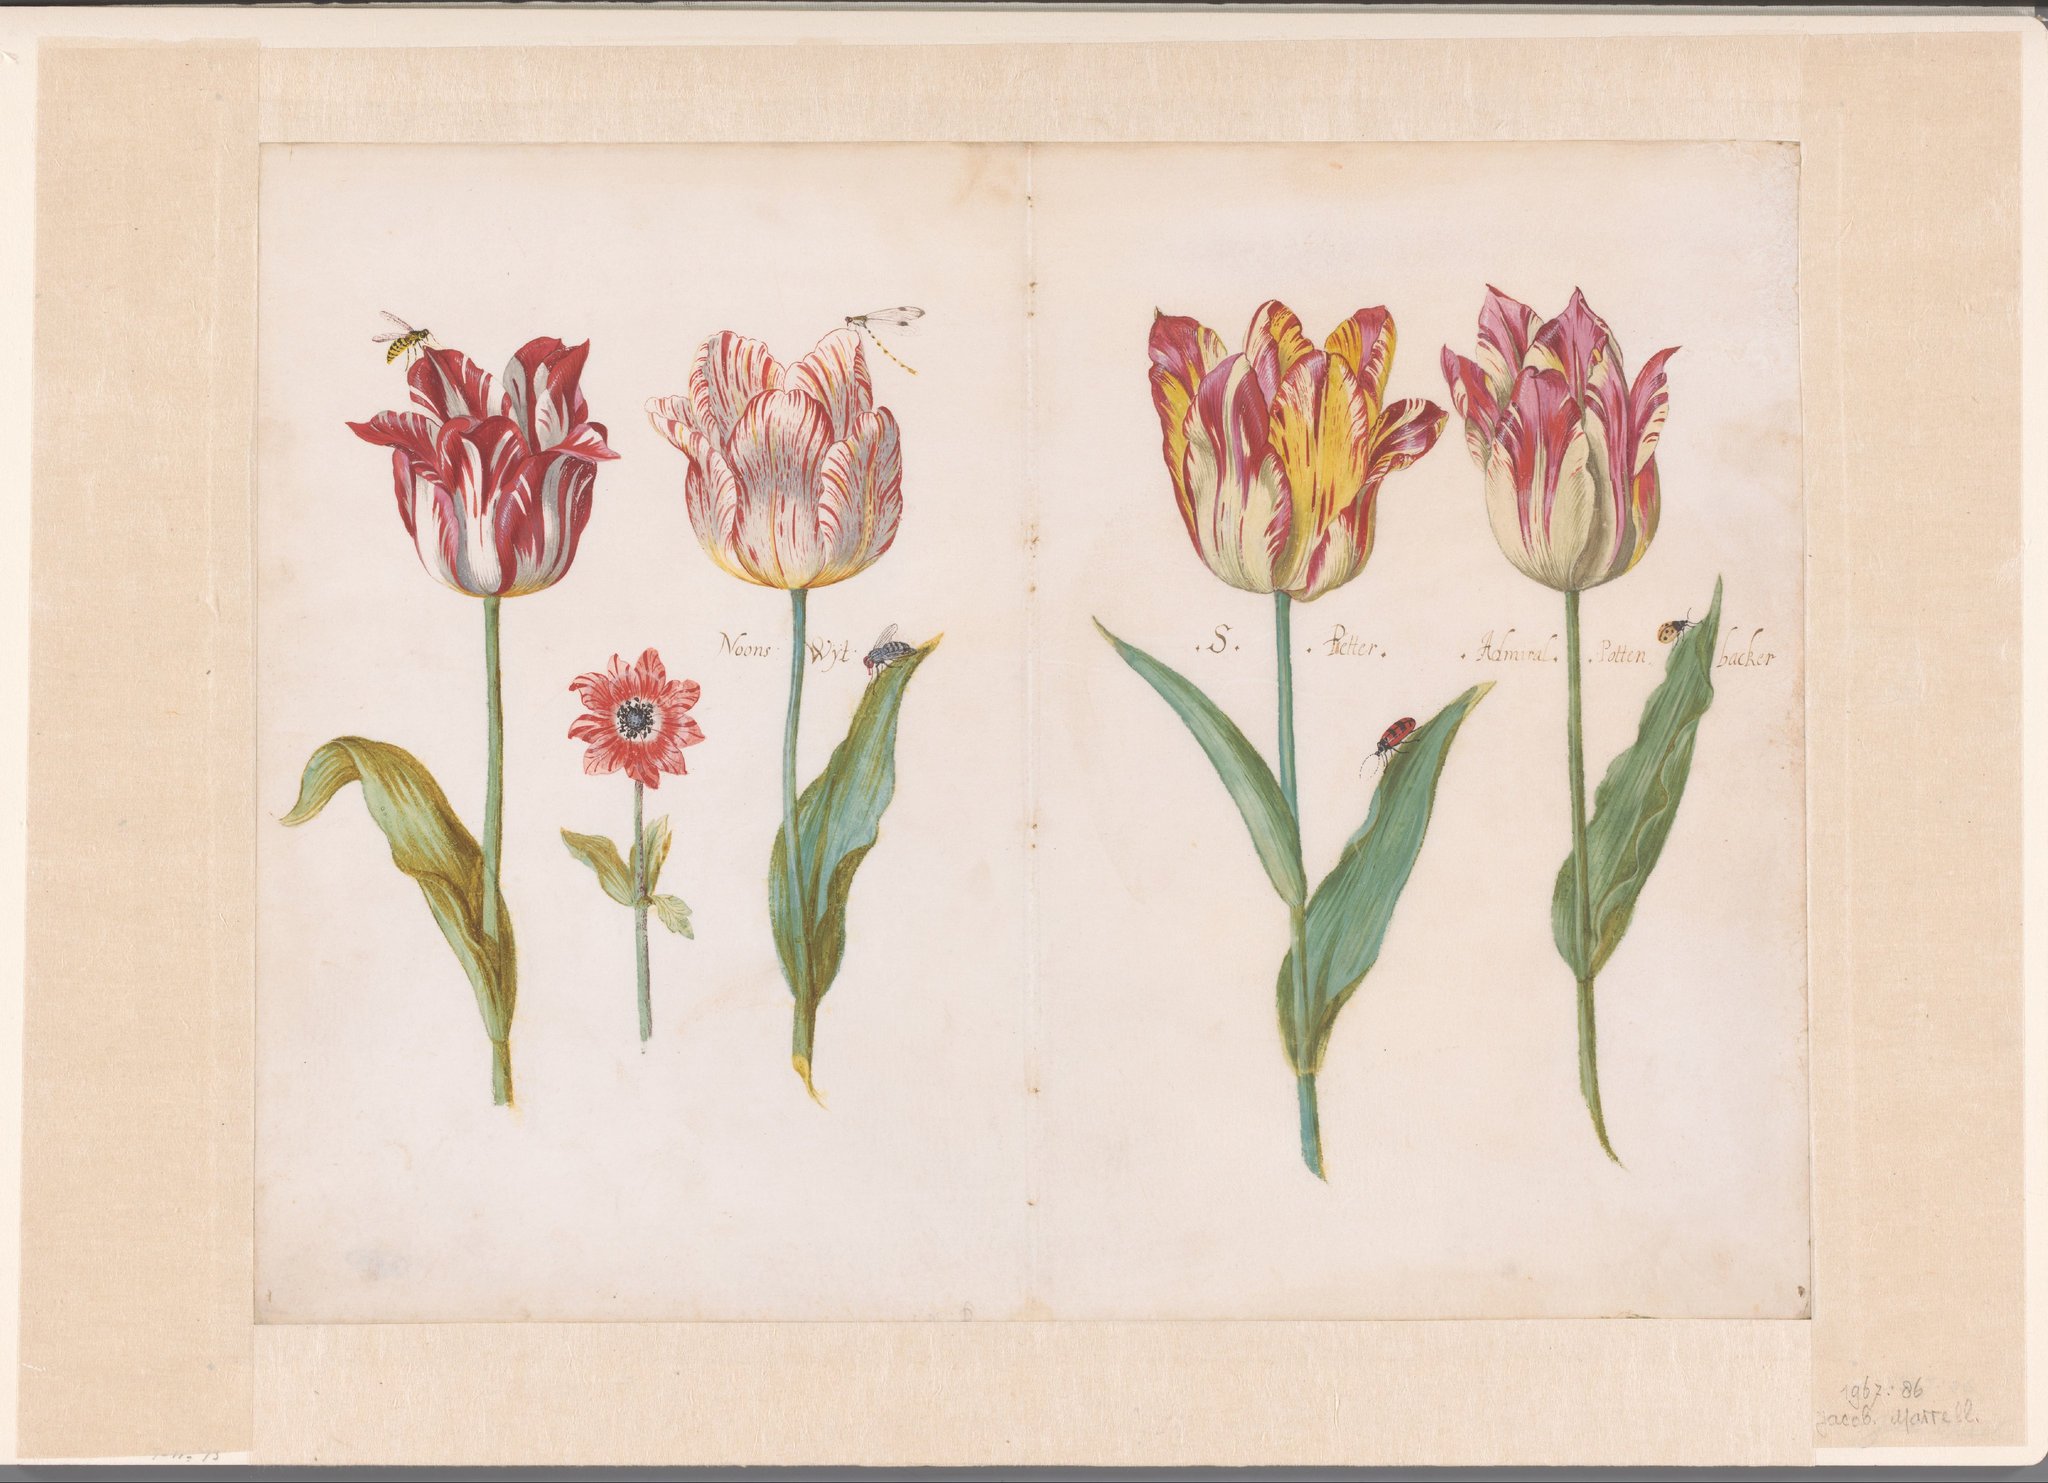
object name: drawing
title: Sheet from a Tulip Book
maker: jacob marrel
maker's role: draughtsman, painter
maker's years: 1614-1681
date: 1640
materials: gouache, parchment, watercolor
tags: insects: dragon-fly, insects: wasp, flowers: tulip, insects: ladybird, insects: beetle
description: Flowers were costly, and tulips the costliest of all. Tulip bulbs were avidly collected in the 17th century and large sums changed hands for unusual specimens. The tulip book’s exact function is not known. It could have been a catalogue from which an interested buyer made his selection, or a drawn inventory of a collection of tulips.